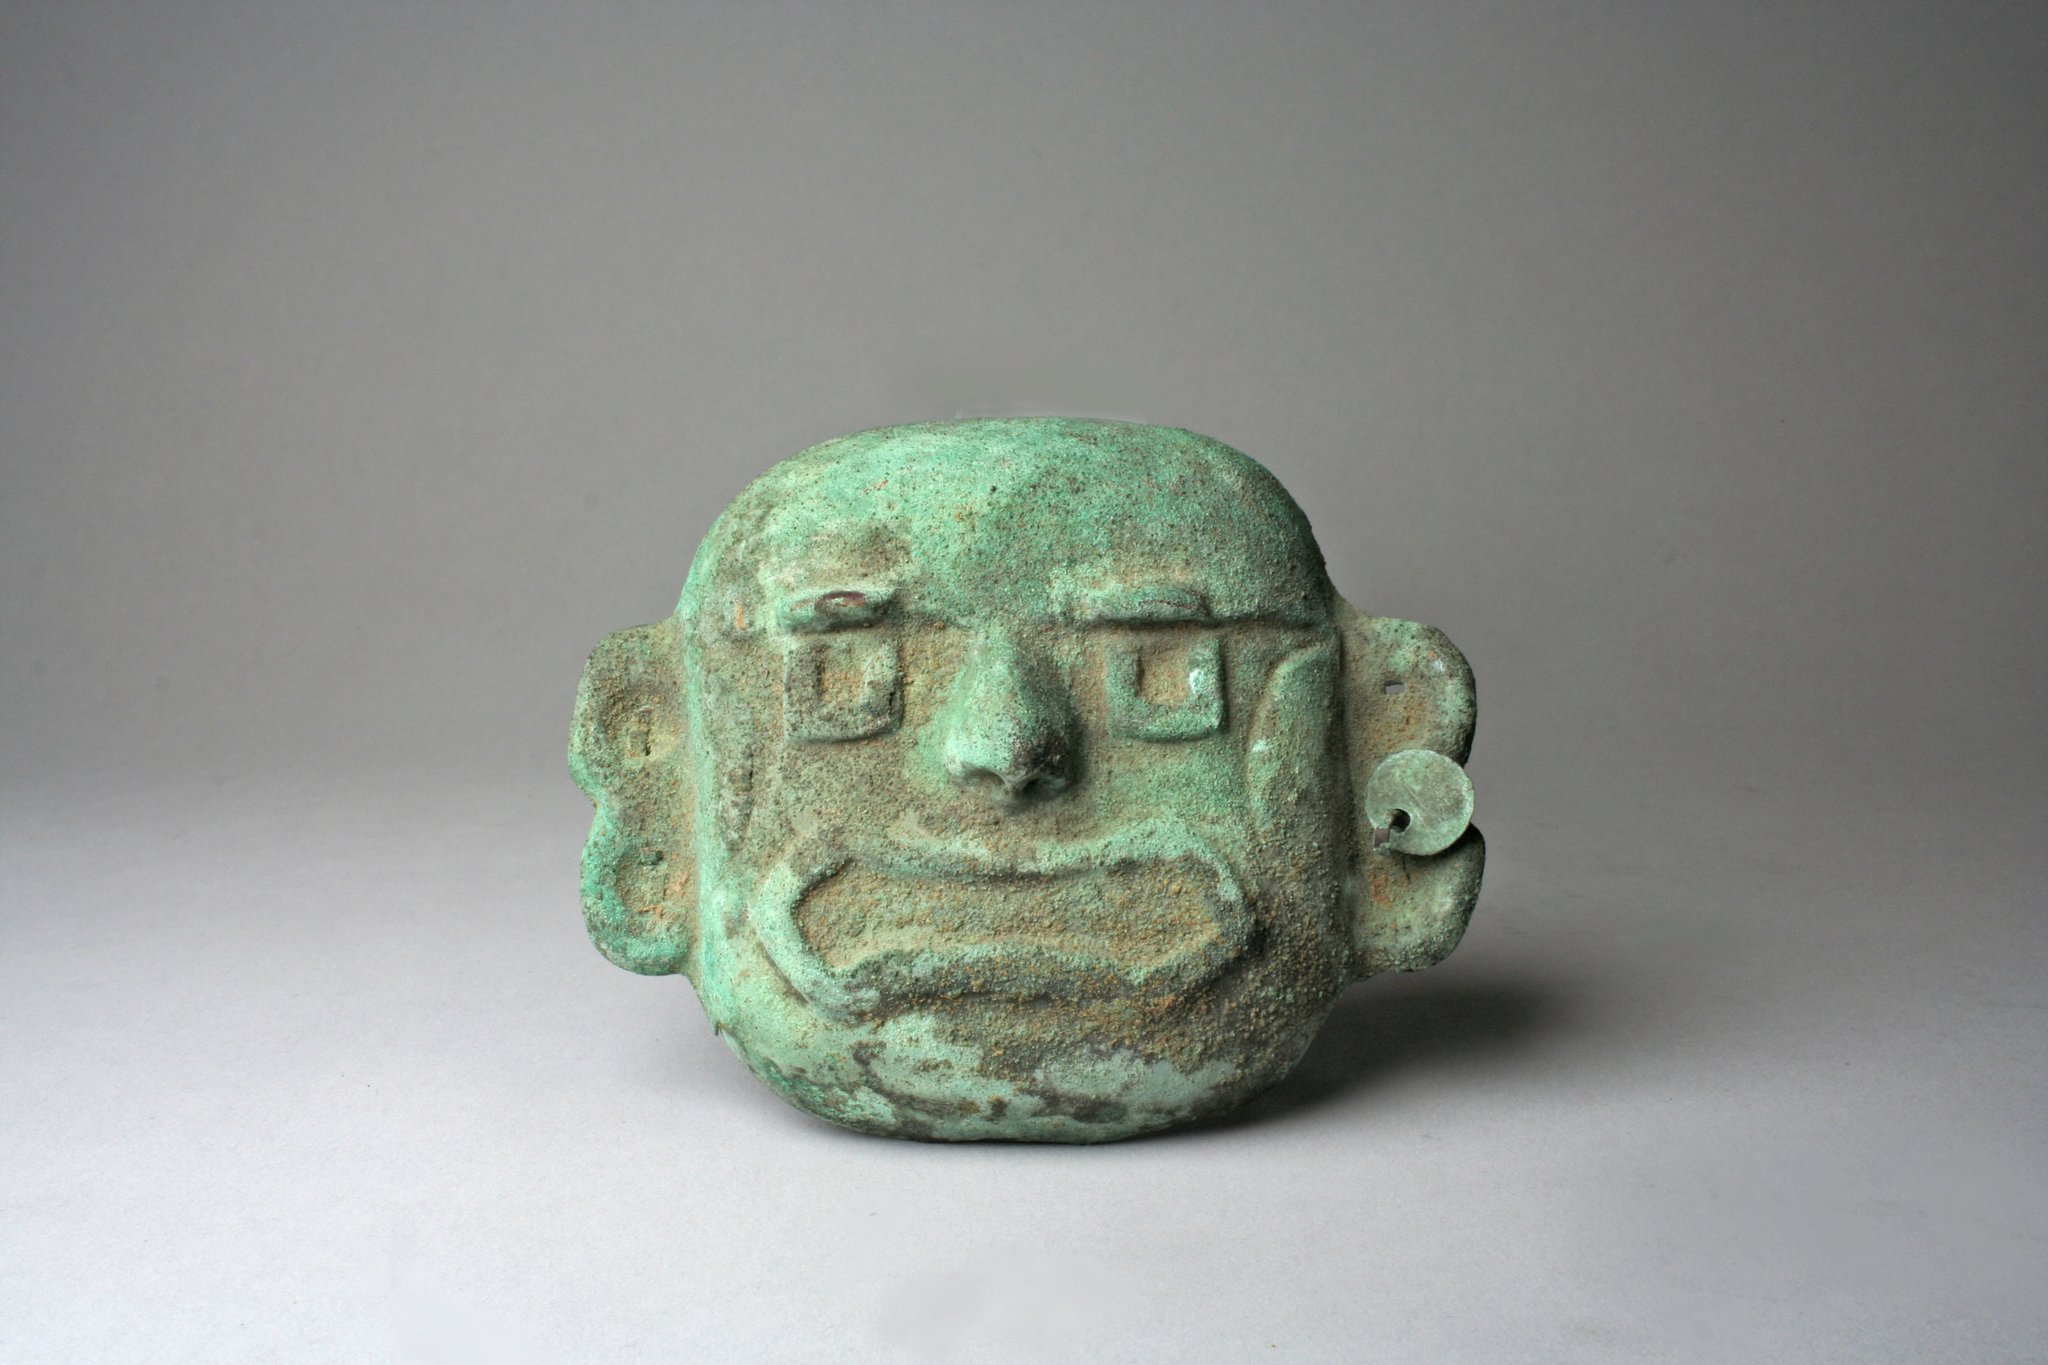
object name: ornament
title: Face Mask Ornament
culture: moche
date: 501-700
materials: copper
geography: peru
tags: masks